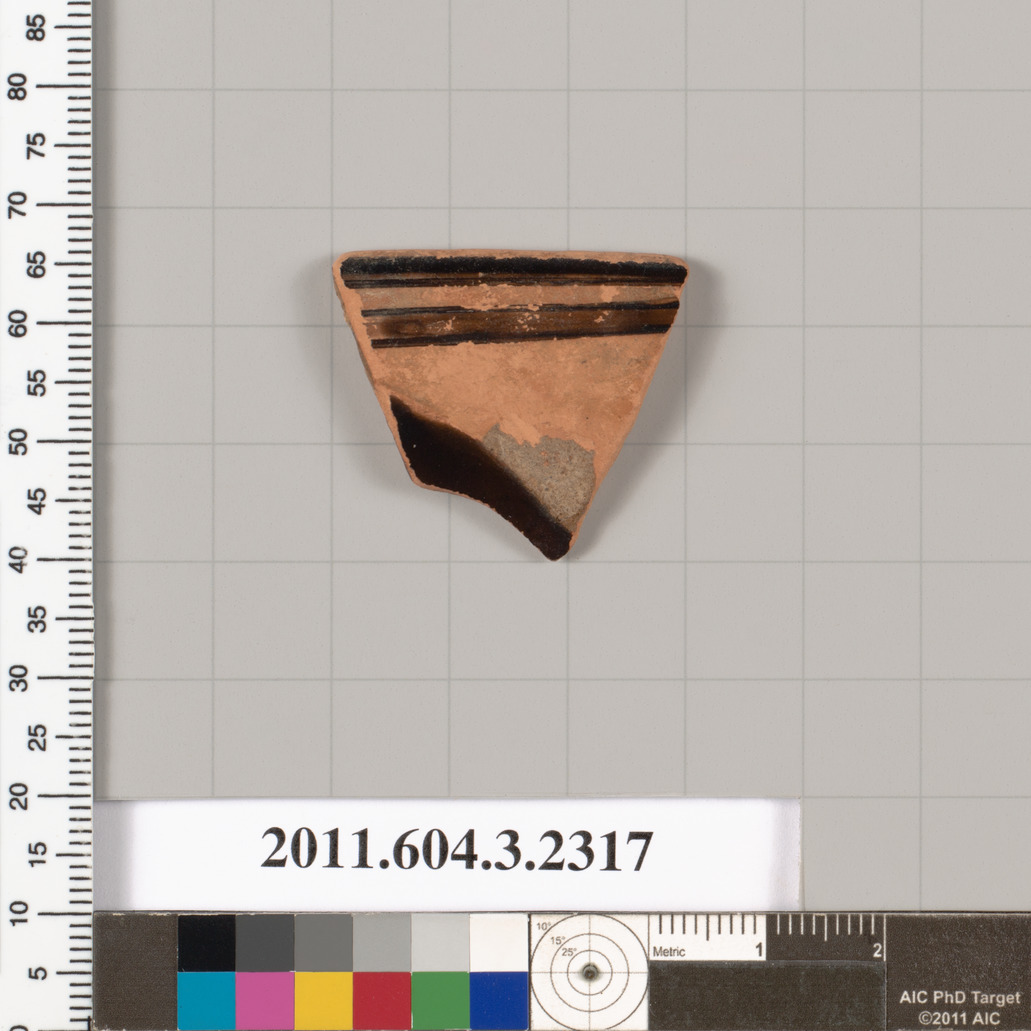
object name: kylix fragment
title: Terracotta rim fragment of a kylix: eye-cup (drinking cup)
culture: greek, attic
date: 530-500 BCE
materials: terracotta